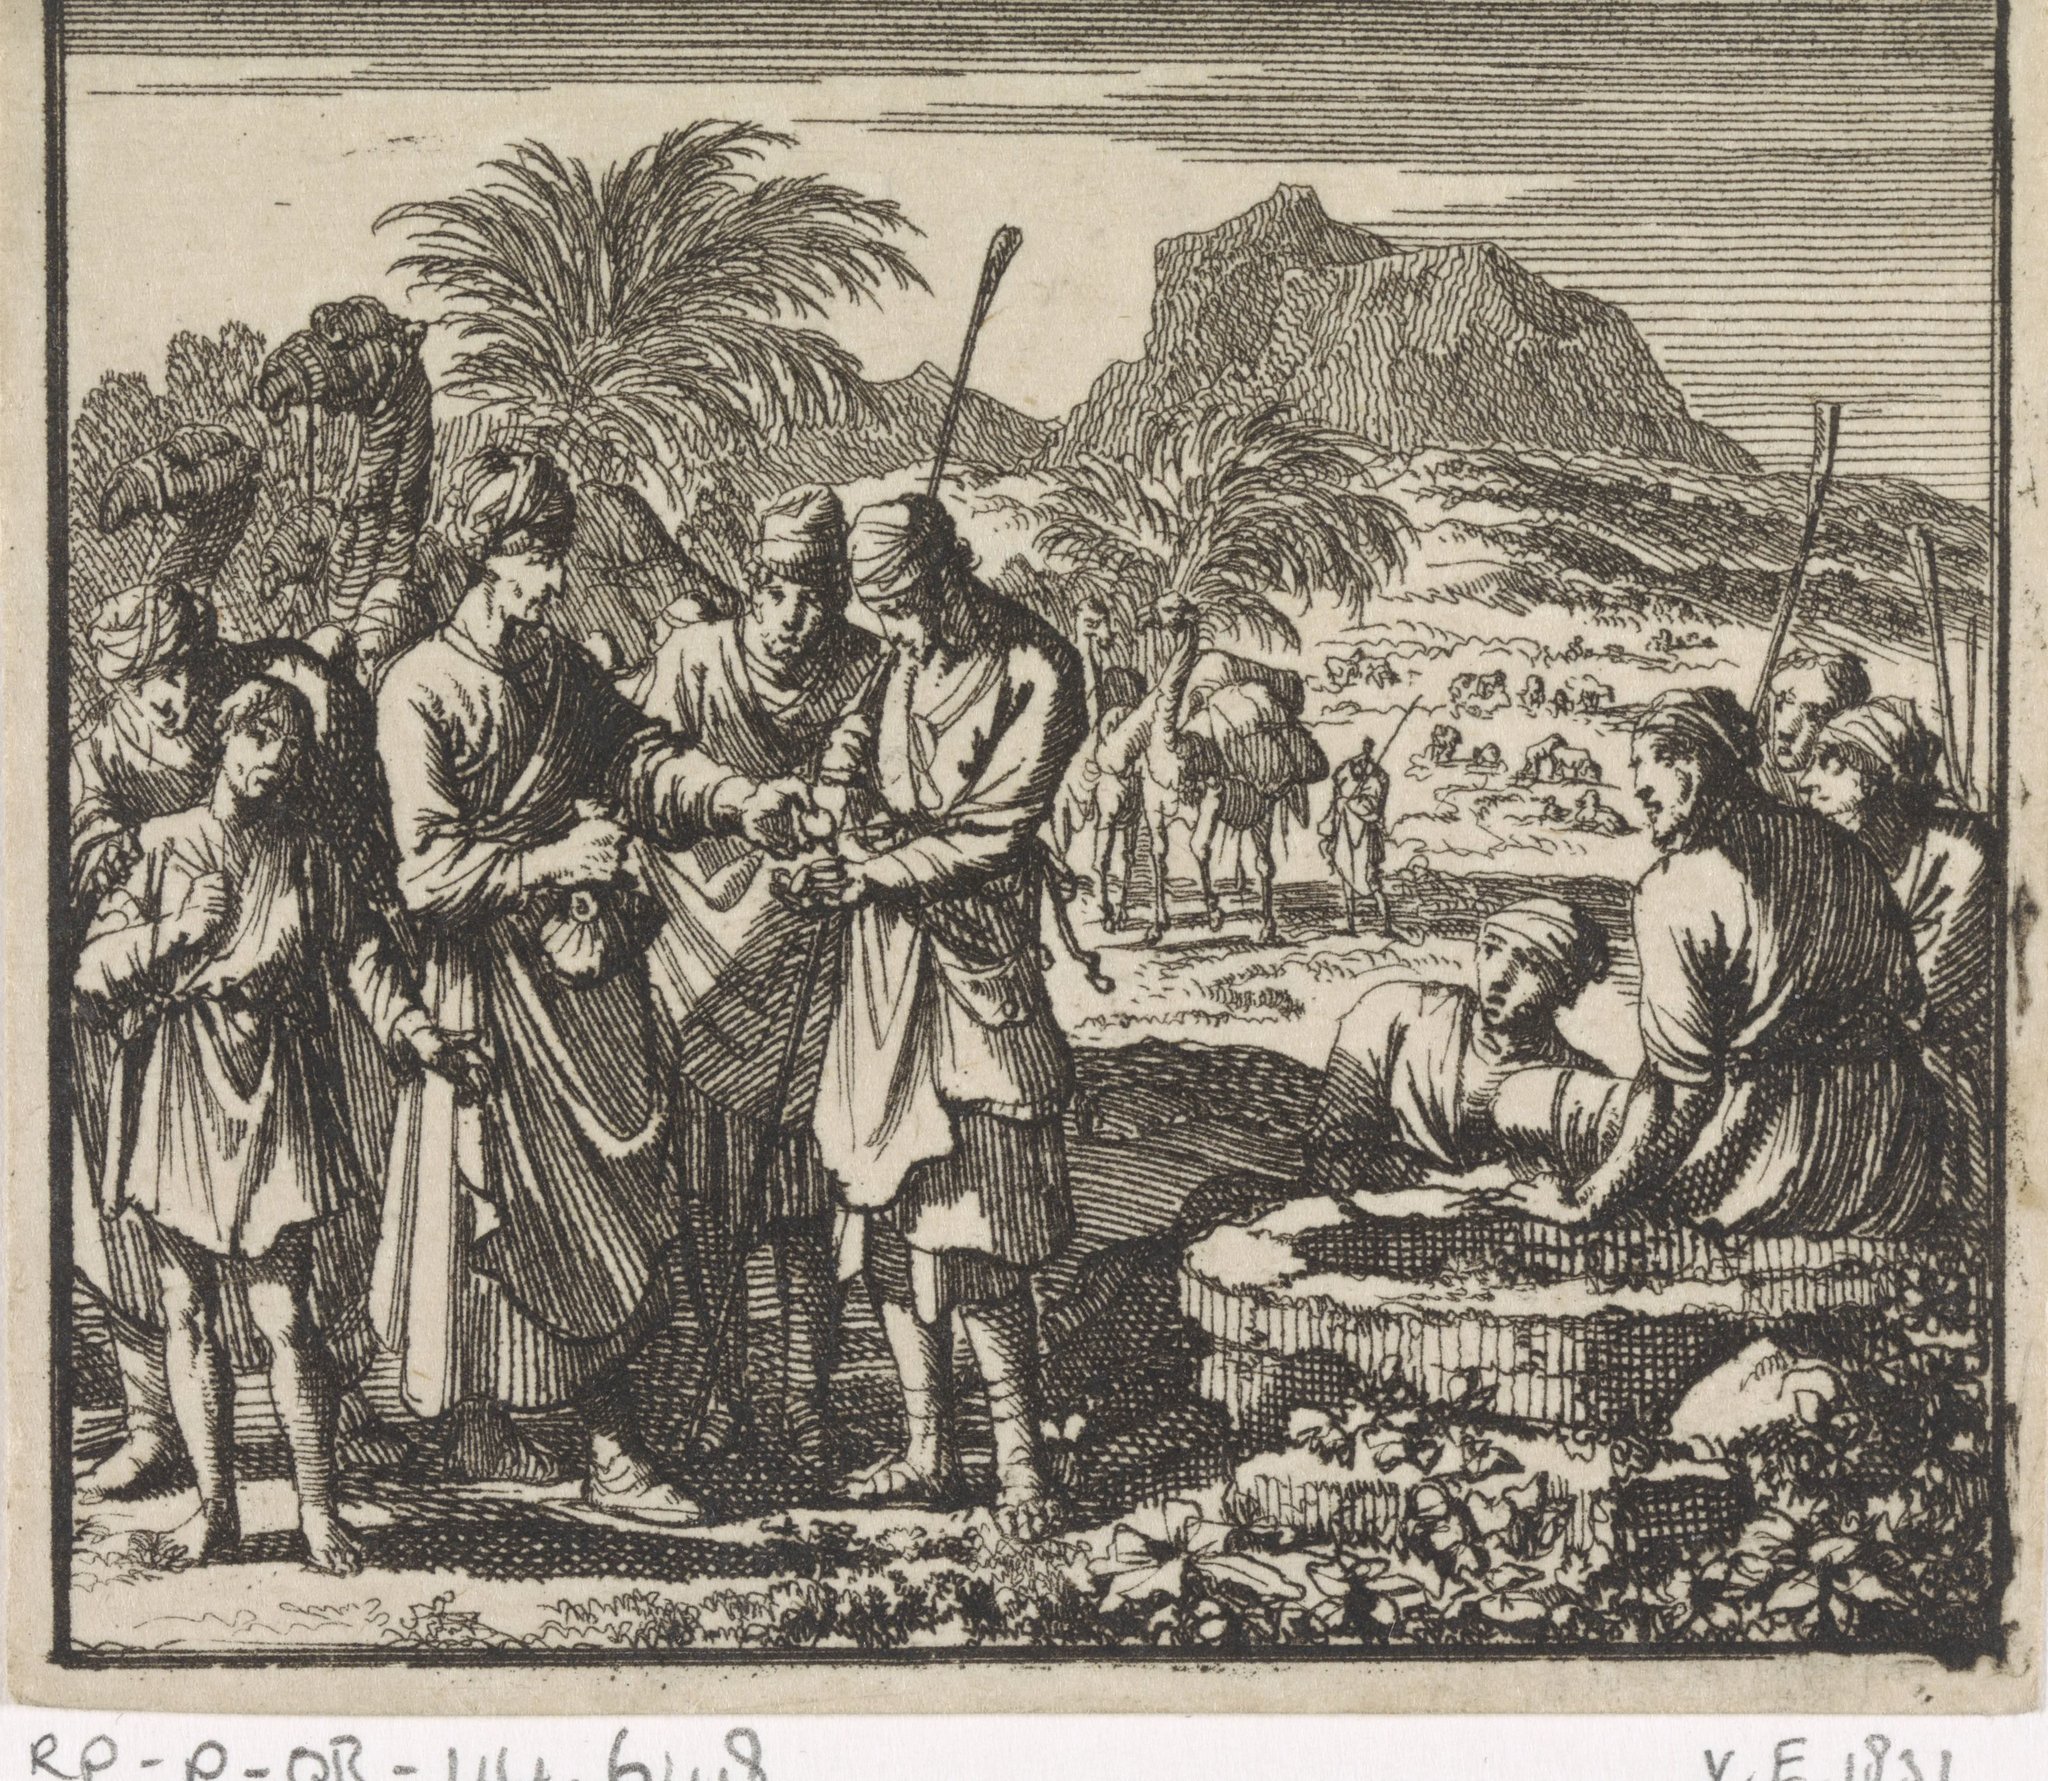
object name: print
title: Jozef door zijn broers verkocht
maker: jan luyken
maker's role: draughtsman, print maker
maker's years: 1649-1712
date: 1698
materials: paper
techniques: etching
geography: amsterdam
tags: joseph sold into slavery and taken to egypt (genesis 37:12-35)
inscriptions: collector's mark: Lugt 2228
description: Proefdruk van illustratie uit: Josephus, Flavius. XX. boeken van de oude geschiedenissen der joden, 4 delen. Amsterdam: Barent Visscher, Willem de Coup, Willem van Lamsveld, Andries van Damme, 1698, dl. I.